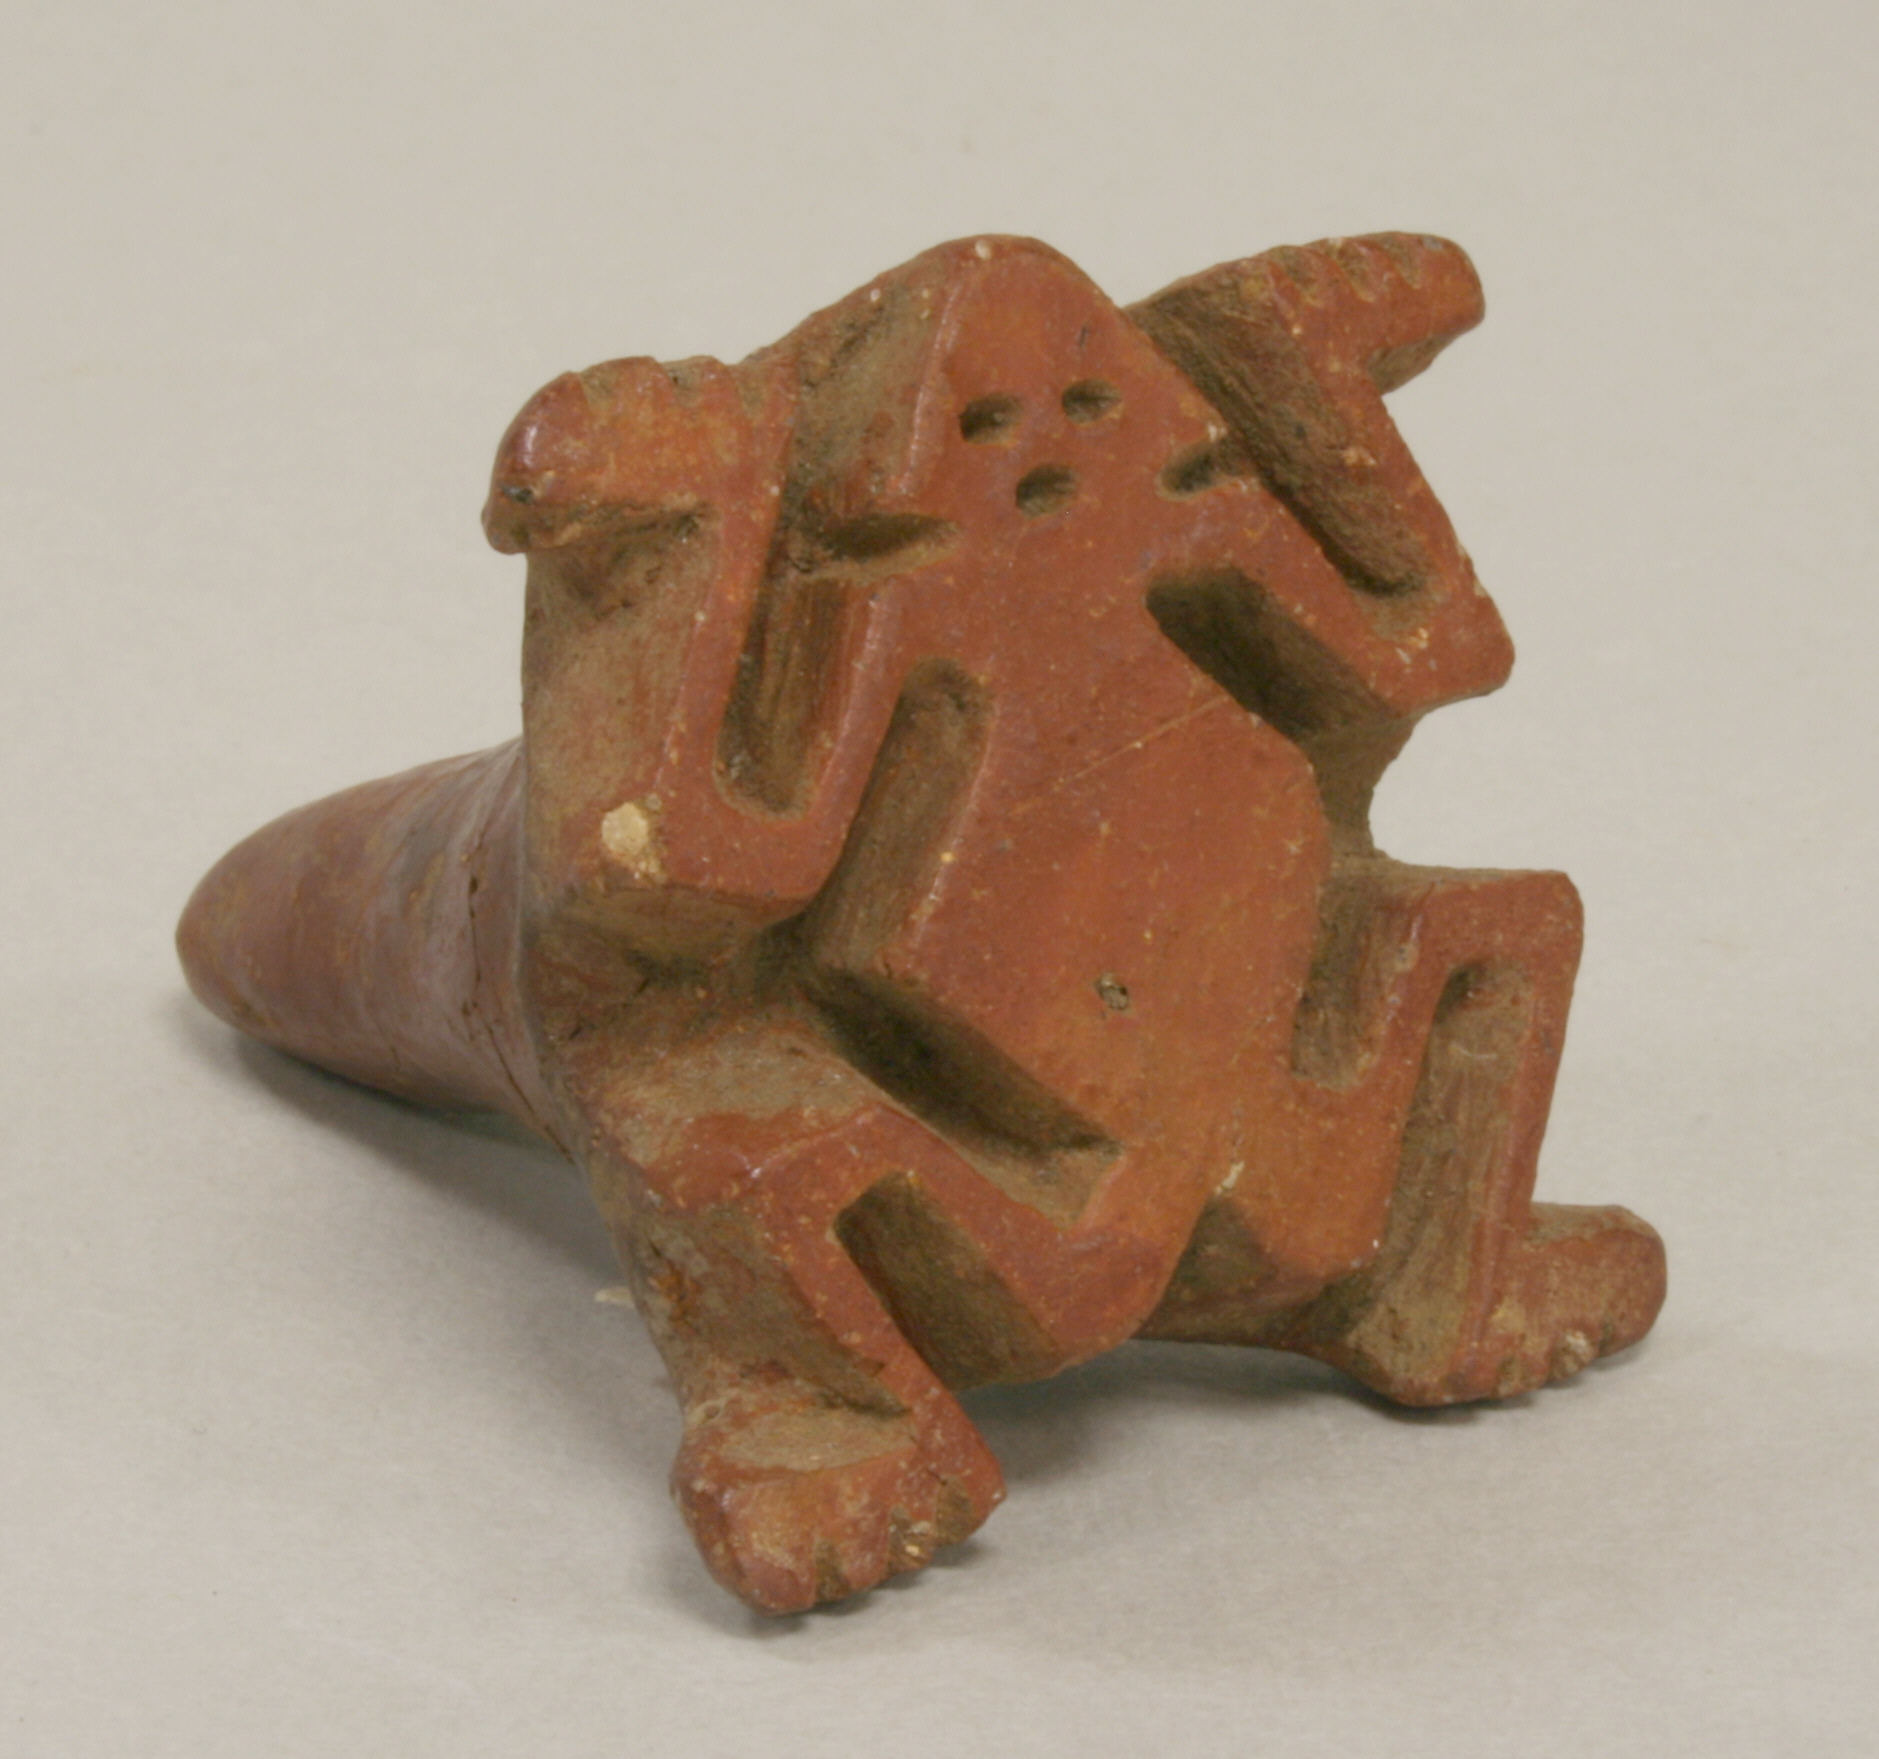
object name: stamp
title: Figure Stamp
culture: atlantic watershed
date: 1-700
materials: ceramic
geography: costa rica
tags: human figures